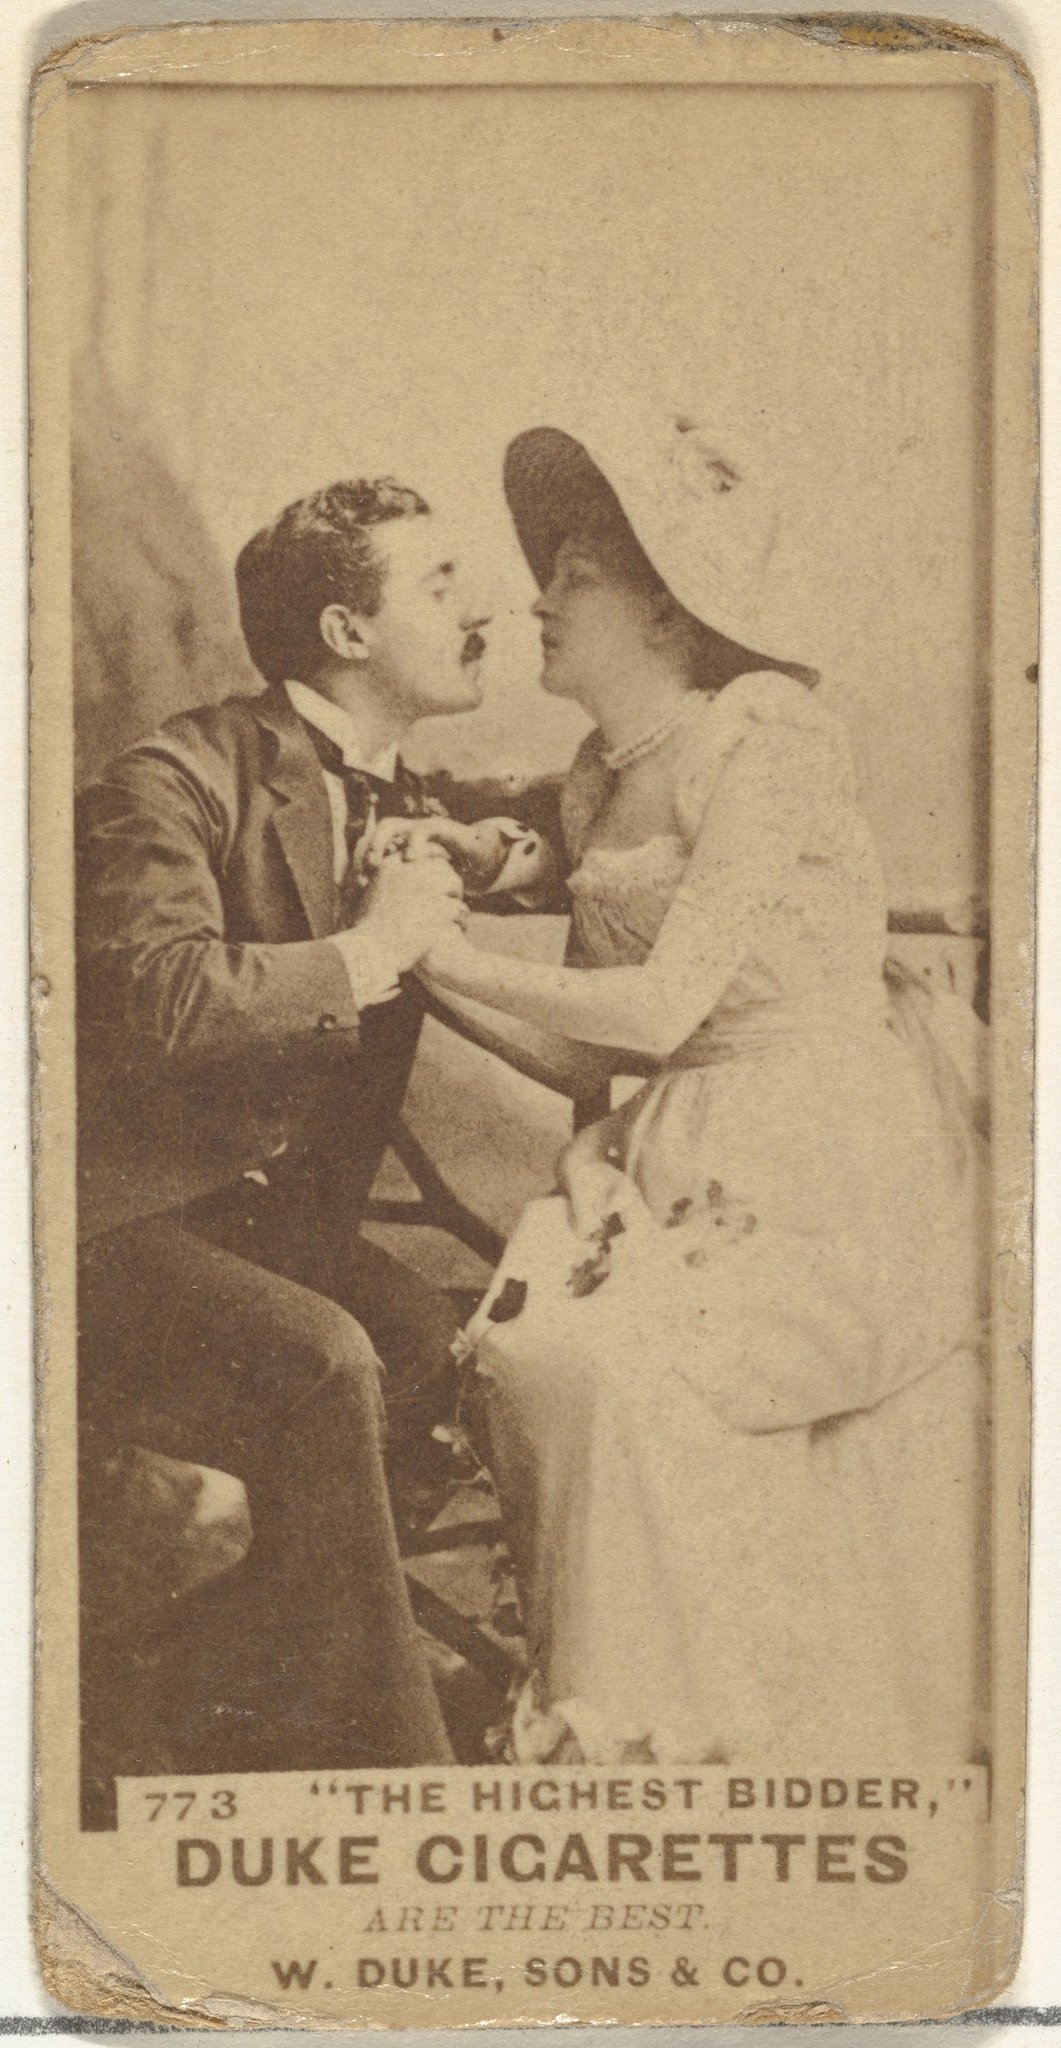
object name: photograph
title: Card Number 773, "The Highest Bidder," from the Actors and Actresses series (N145-7) issued by Duke Sons & Co. to promote Duke Cigarettes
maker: w. duke, sons & co.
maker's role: publisher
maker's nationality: american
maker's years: 1870-1920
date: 1880-1889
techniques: albumen silver print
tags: men,women,actresses